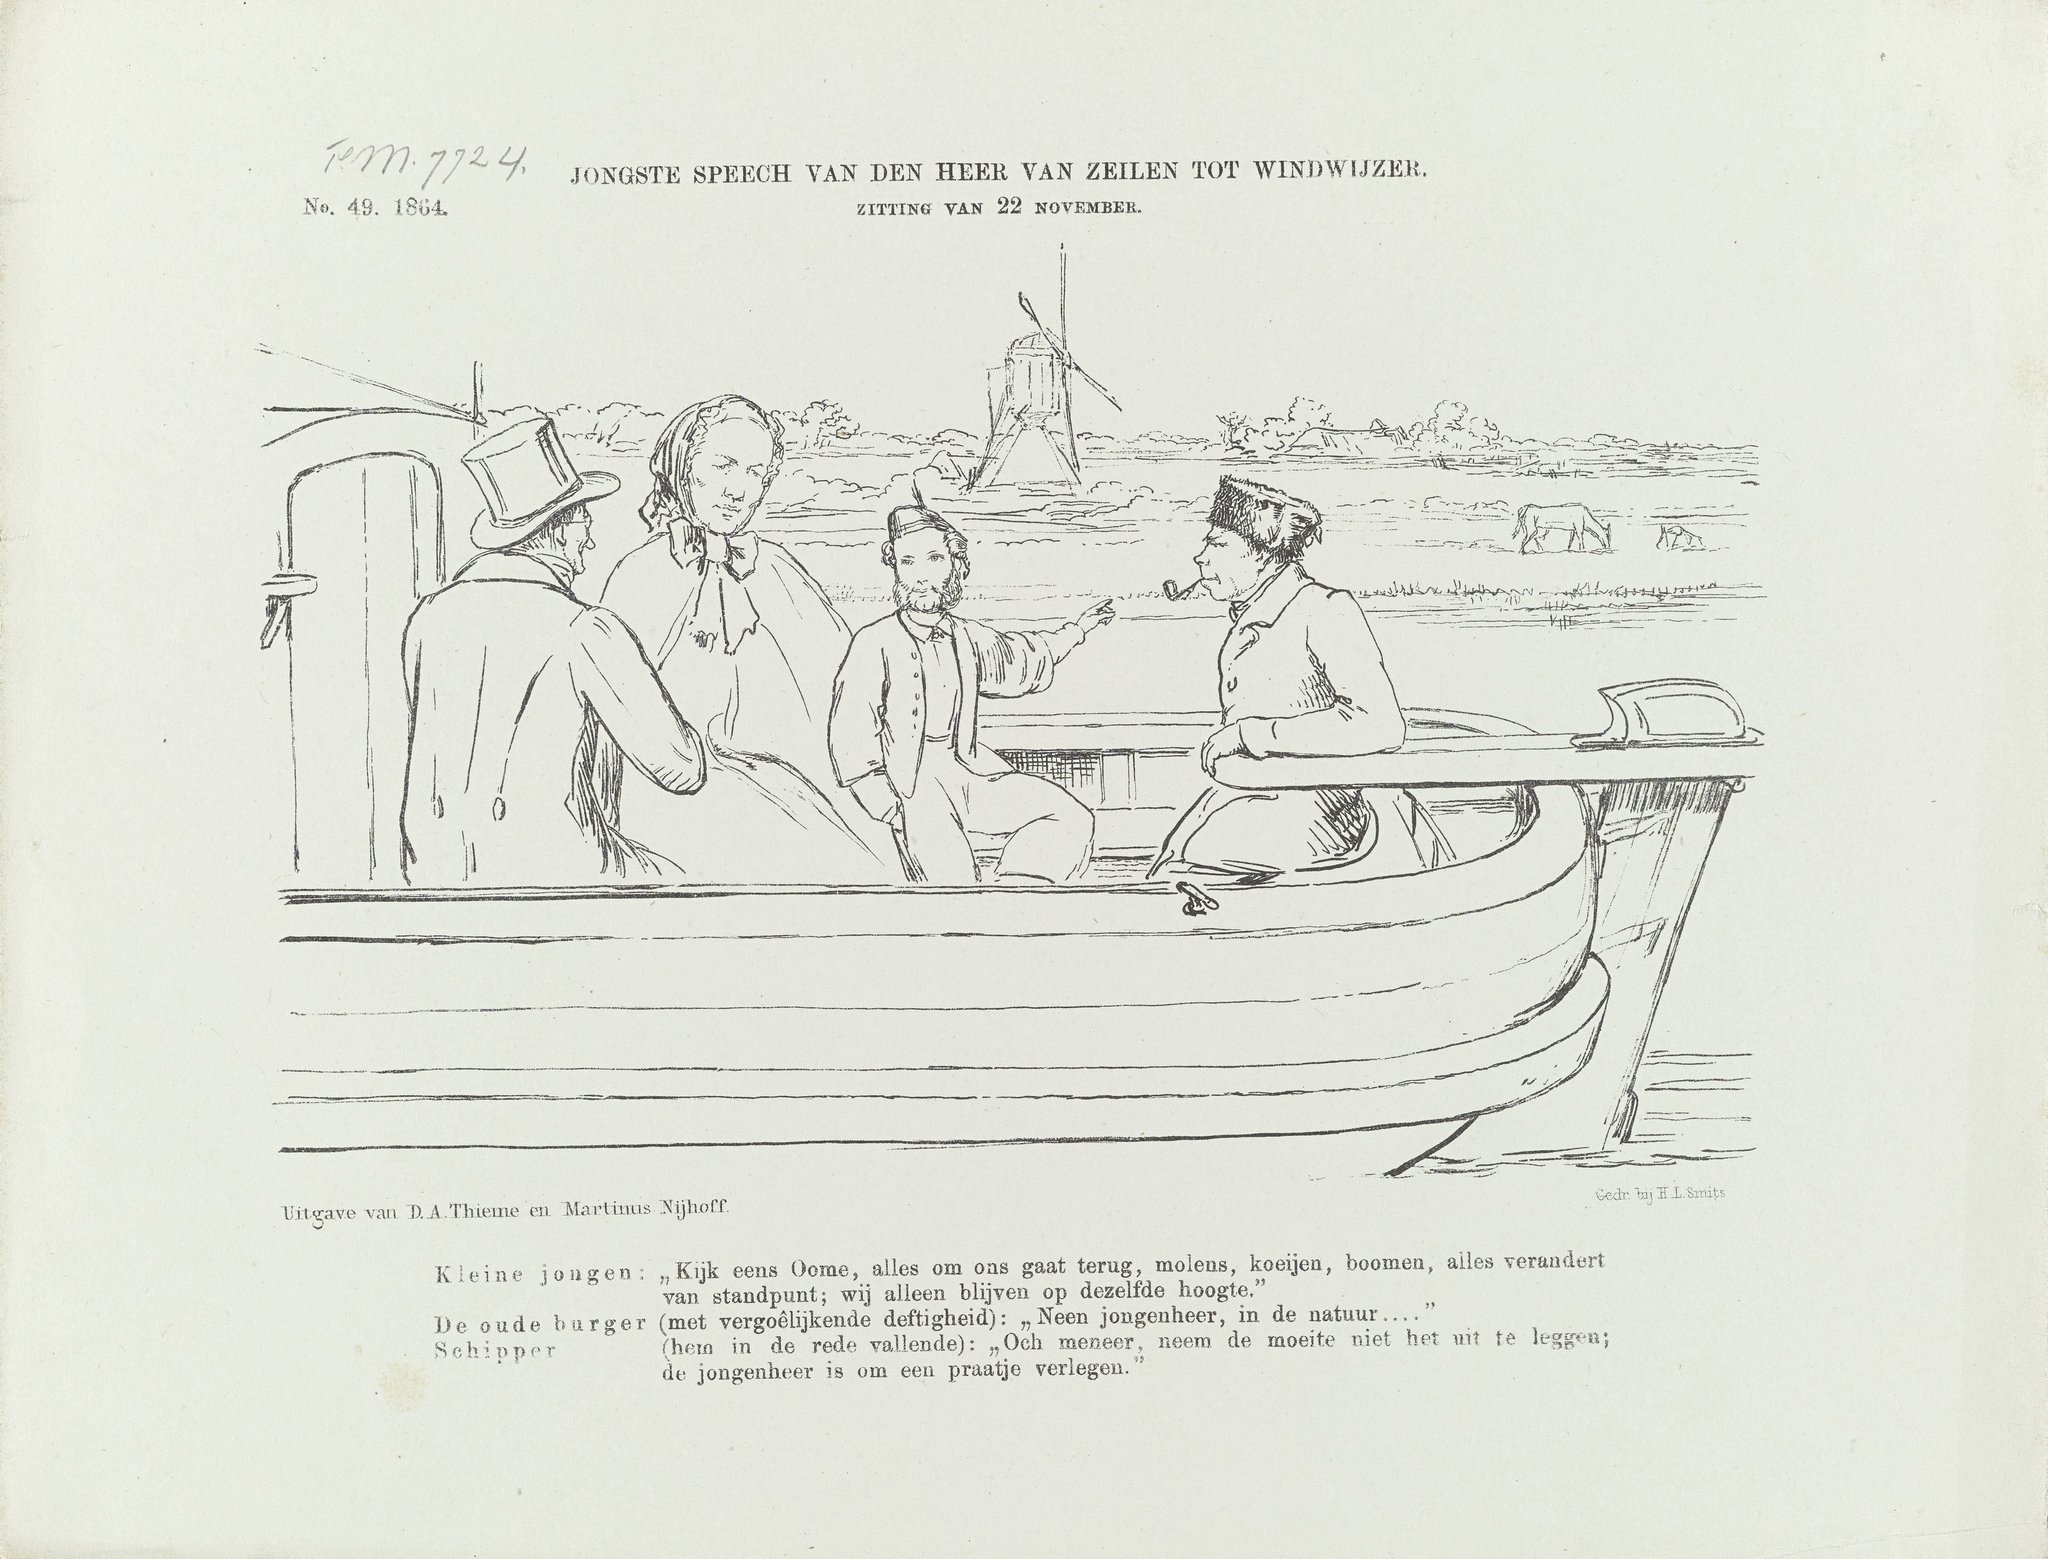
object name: print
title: Spotprent op baron Van Zuylen van Nijevelt, 1864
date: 1864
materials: paper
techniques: lithograph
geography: the hague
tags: tow-boat, towing-barge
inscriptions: collector's mark: Lugt 2228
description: Spotprent op een toespraak door baron Van Zuylen van Nijevelt gehouden op 22 november 1864. Vier personen pratend in een trekschuit, de baron voorgesteld als een kleine jongen. Plaat verschenen bij het weekblad De Nederlandsche Spectator, nr. 49, 3 december 1864.